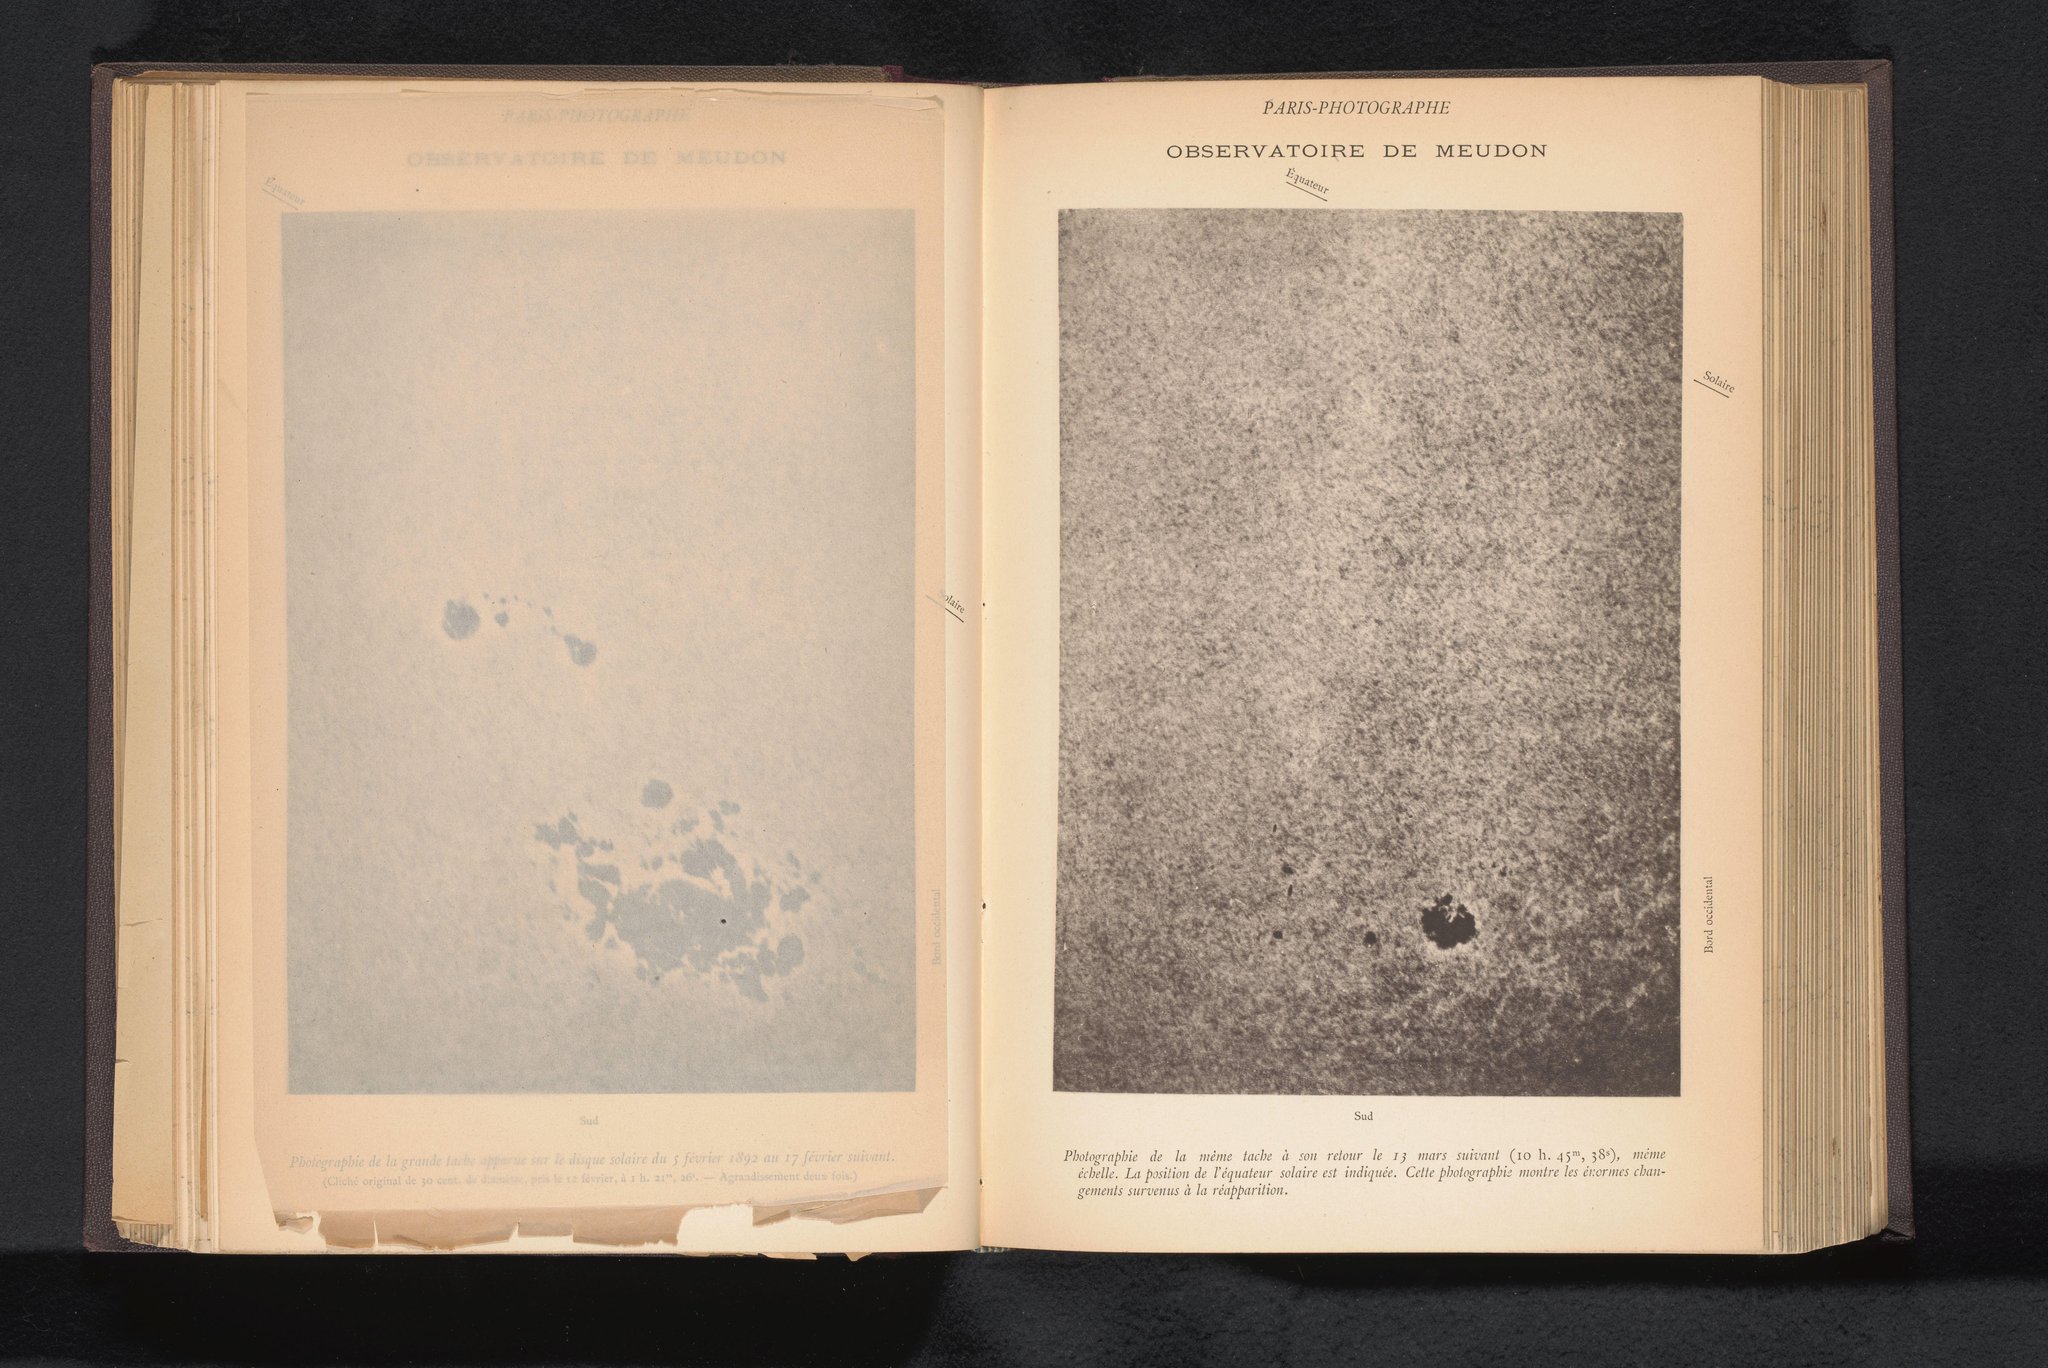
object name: page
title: Zonnevlek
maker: Anonymous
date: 1892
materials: paper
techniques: photograph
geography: meudon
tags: sun-spots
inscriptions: inscription: ‘Sud Photographie de la même tache à son retour le 13 mars suivant (...)’